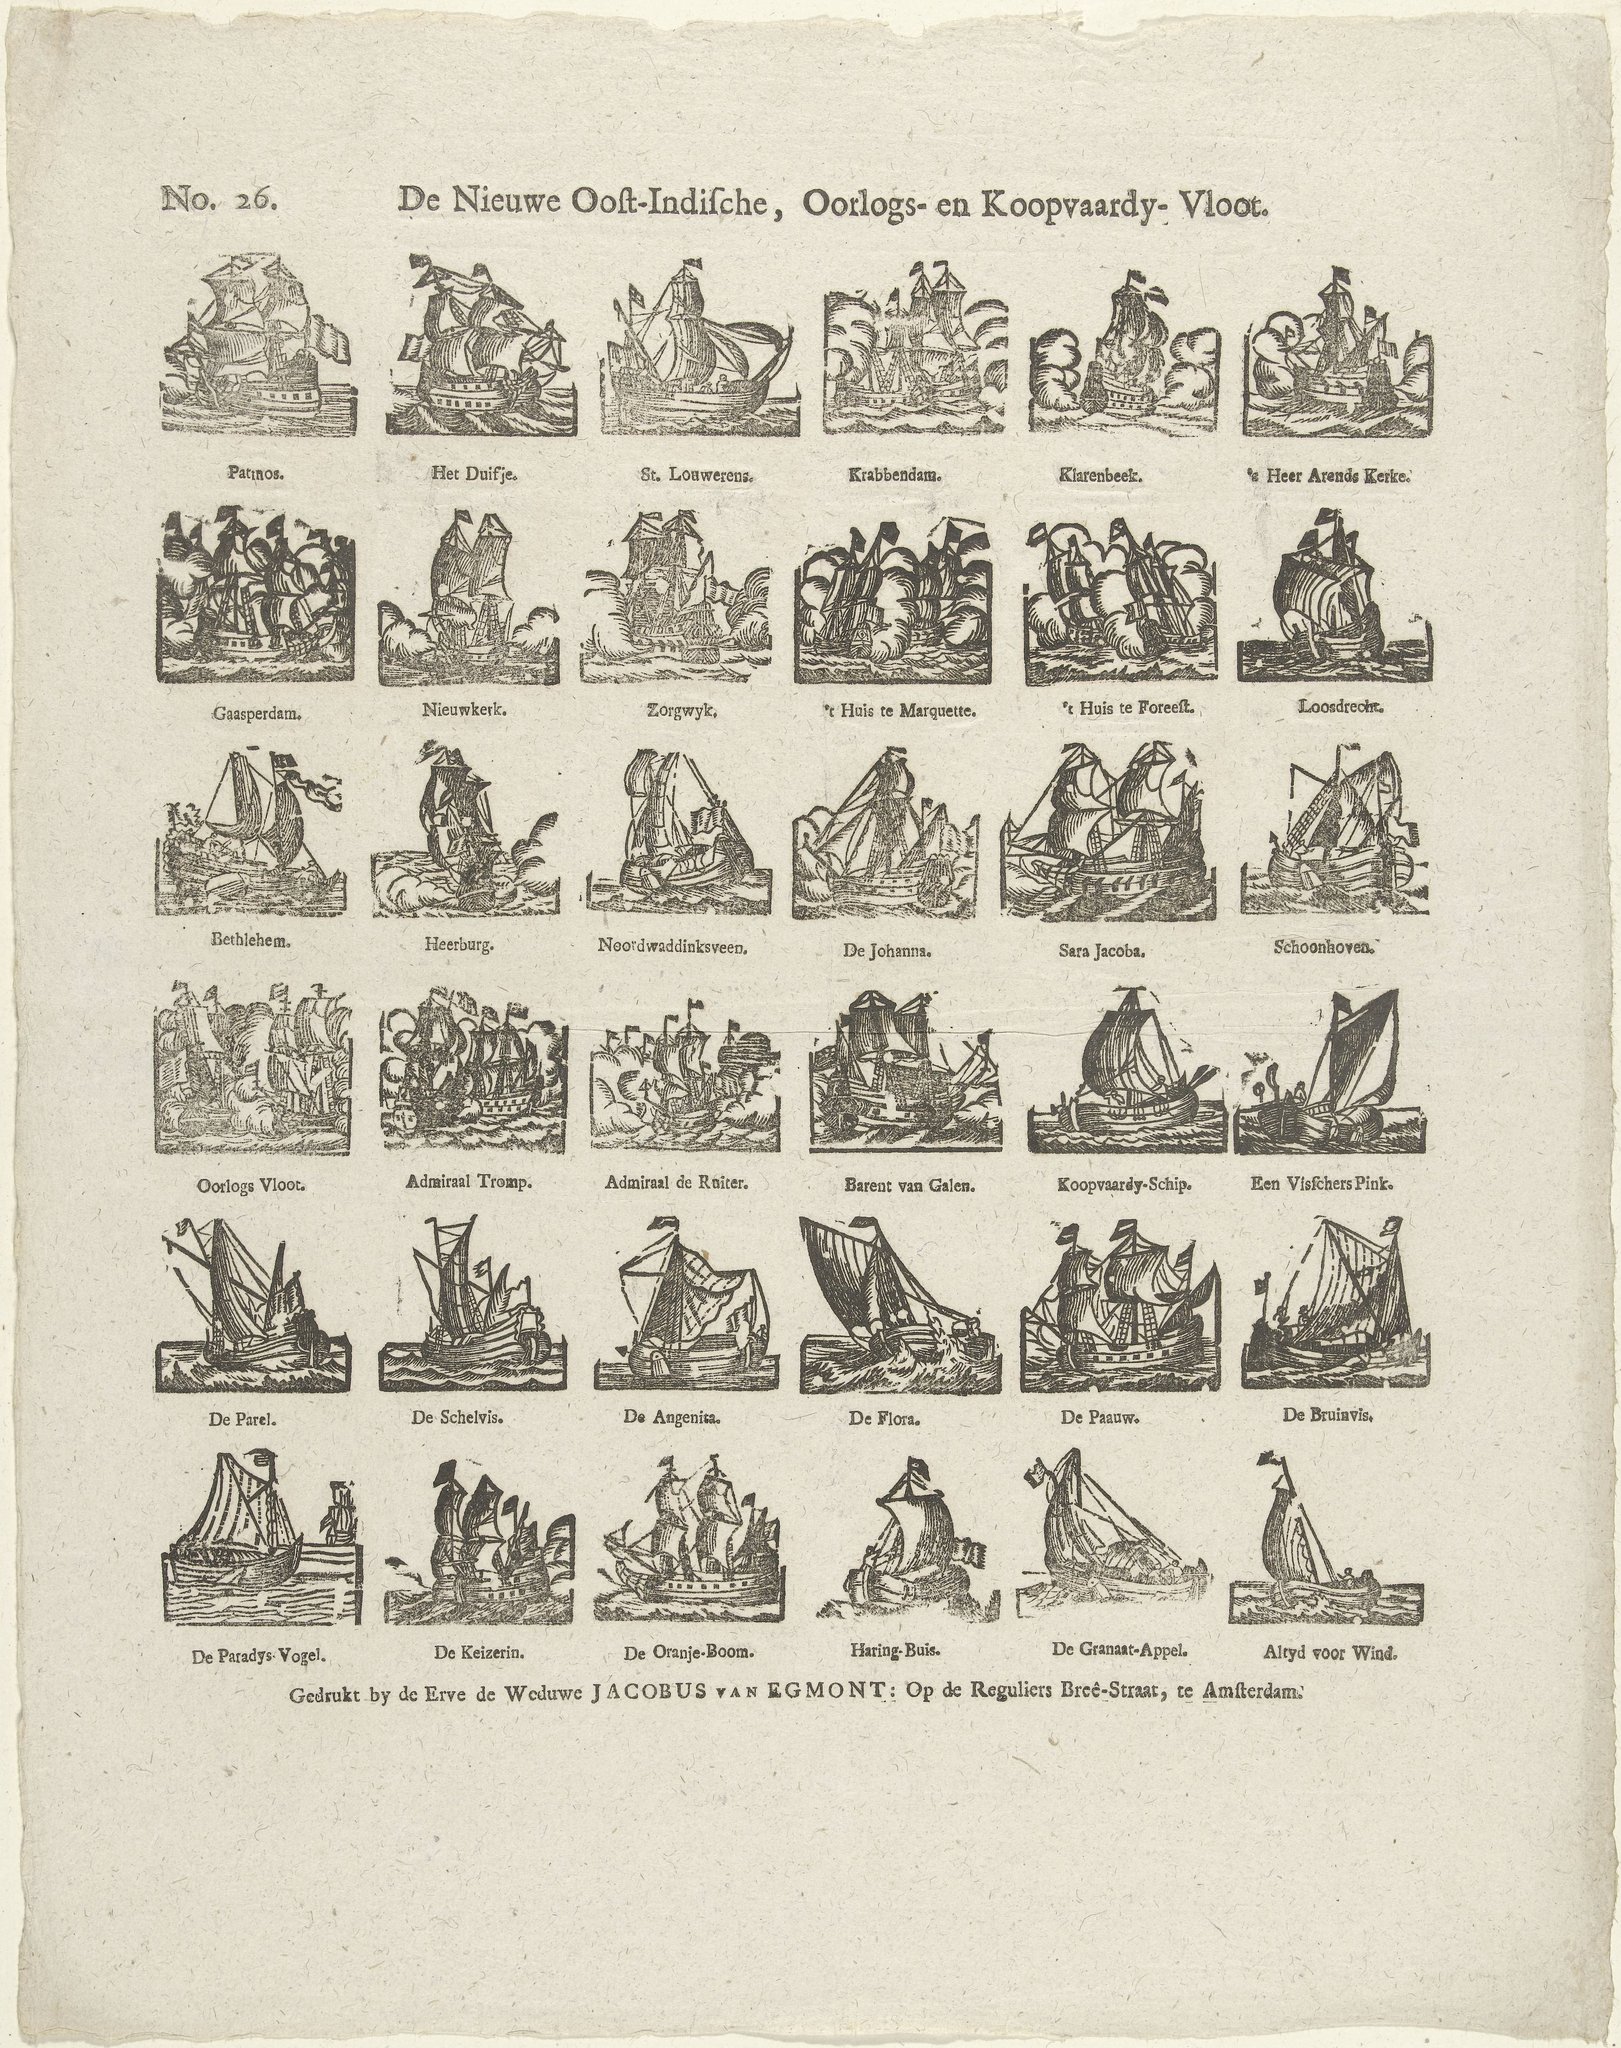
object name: print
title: De nieuwe Oost-Indische, Oorlogs- en koopvaardy-vloot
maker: Anonymous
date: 1761-1804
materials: paper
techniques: letterpress printing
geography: amsterdam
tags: ships (in general) (+ propulsion of vehicle, ship, etc. by wind), ships (in general)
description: Blad met 36 kleine voorstellingen van de oorlogs- en koopvaardijschepen van Oost-Indische vloot. Onder elke voorstelling staat de naam van het afgebeelde schip of de naam van het scheepstype. Genummerd linksboven: No. 26.